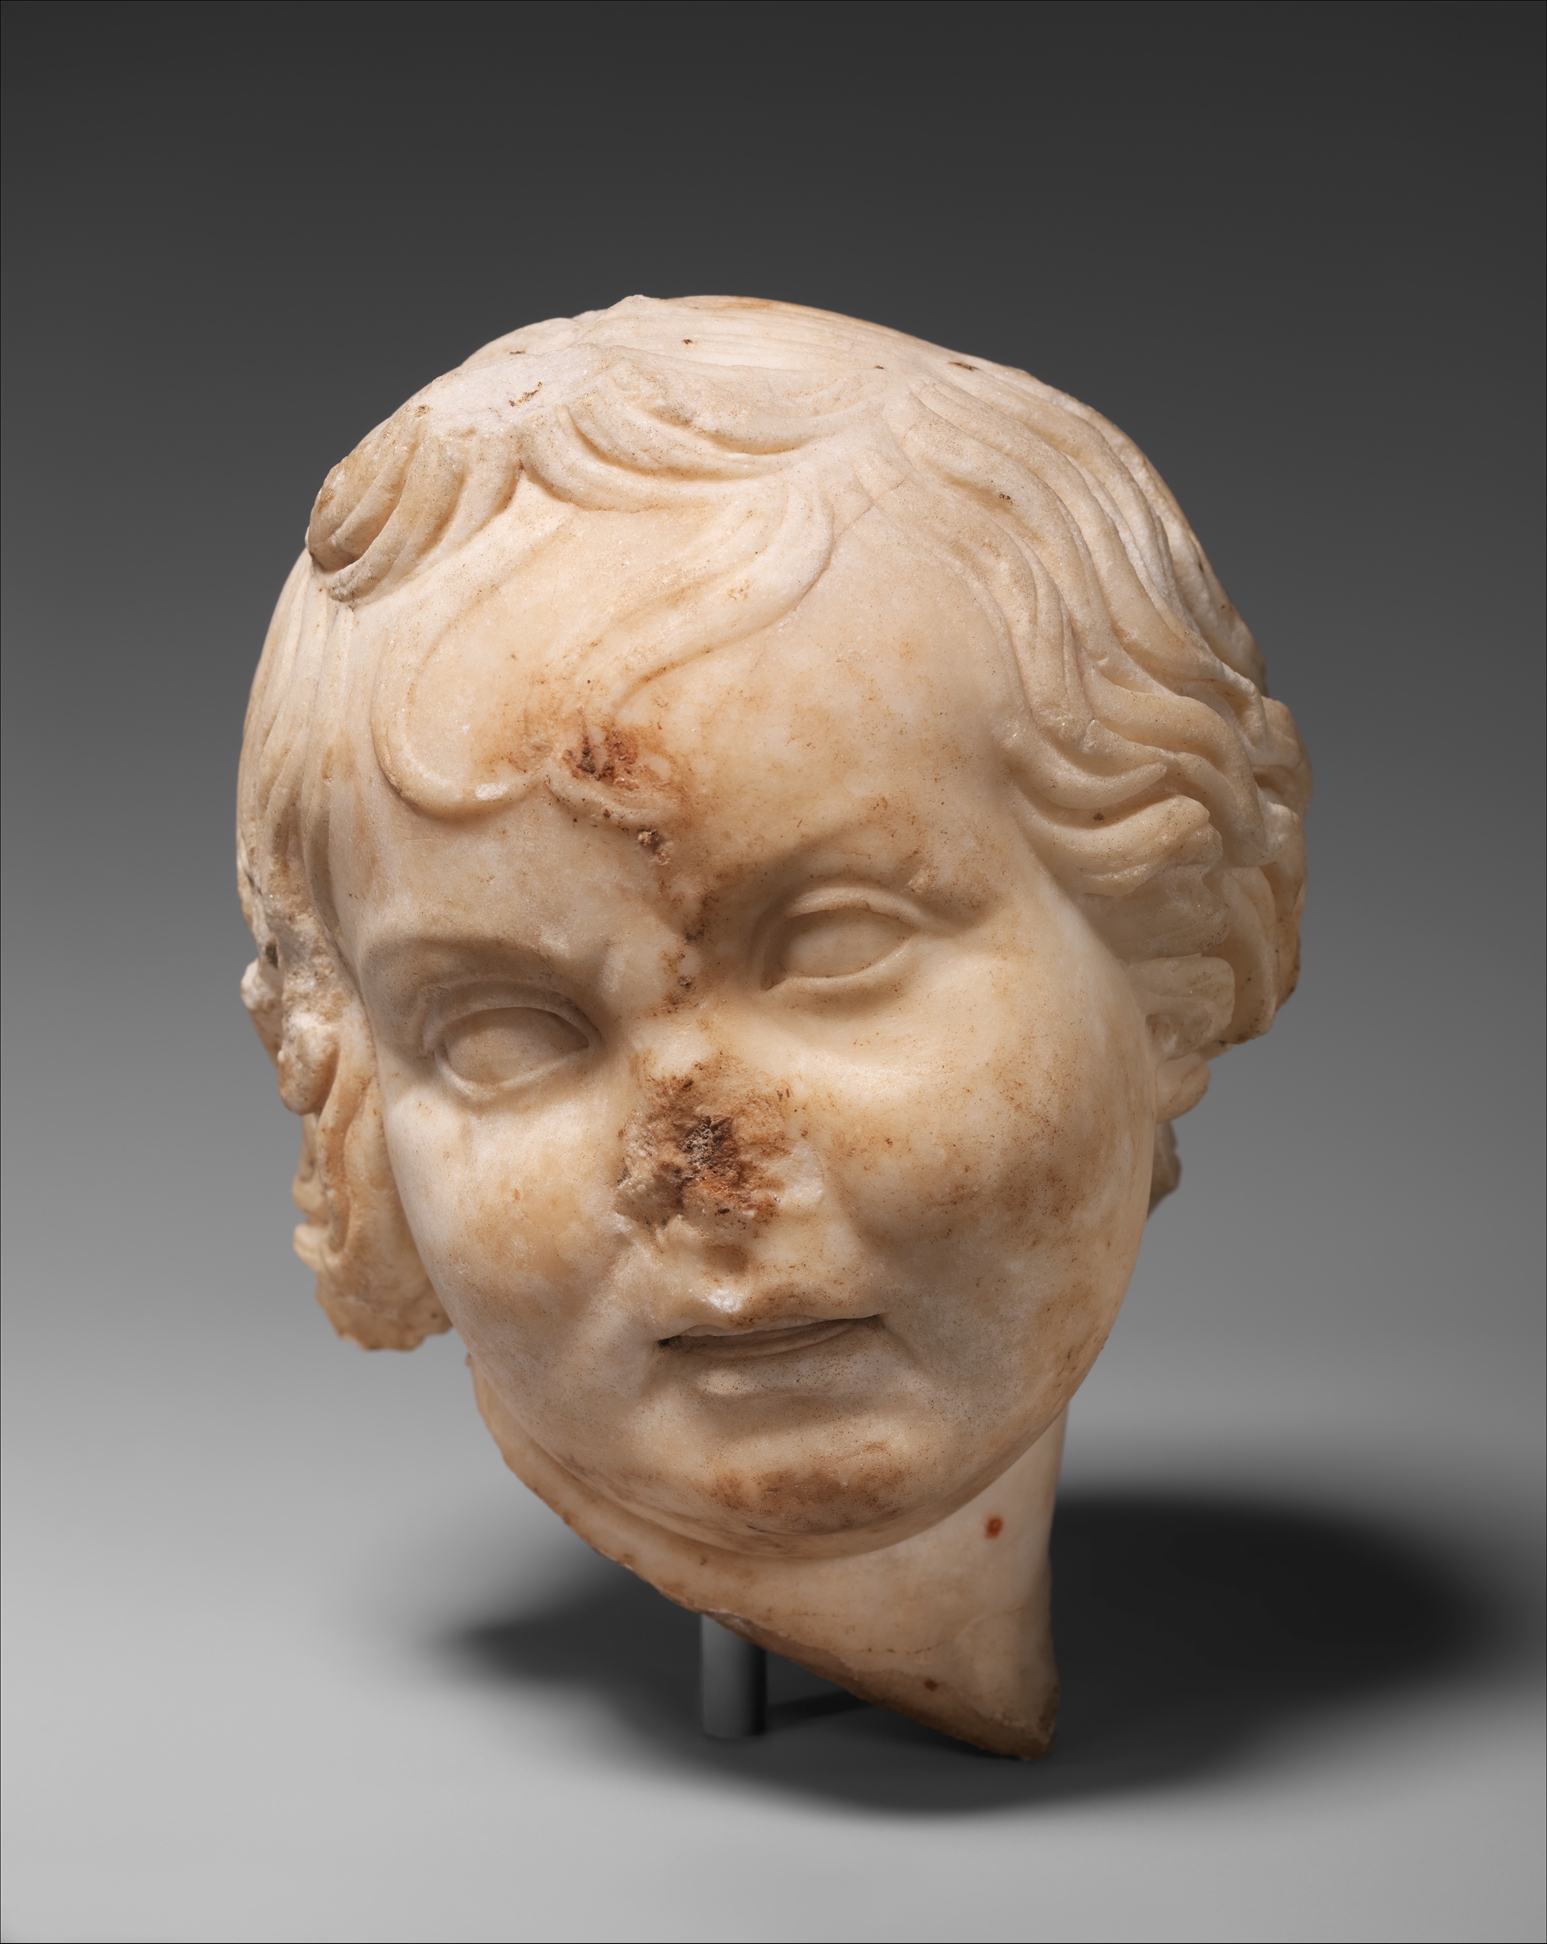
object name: head of a child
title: Marble head of a child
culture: greek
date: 200-101 BCE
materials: marble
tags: heads,children